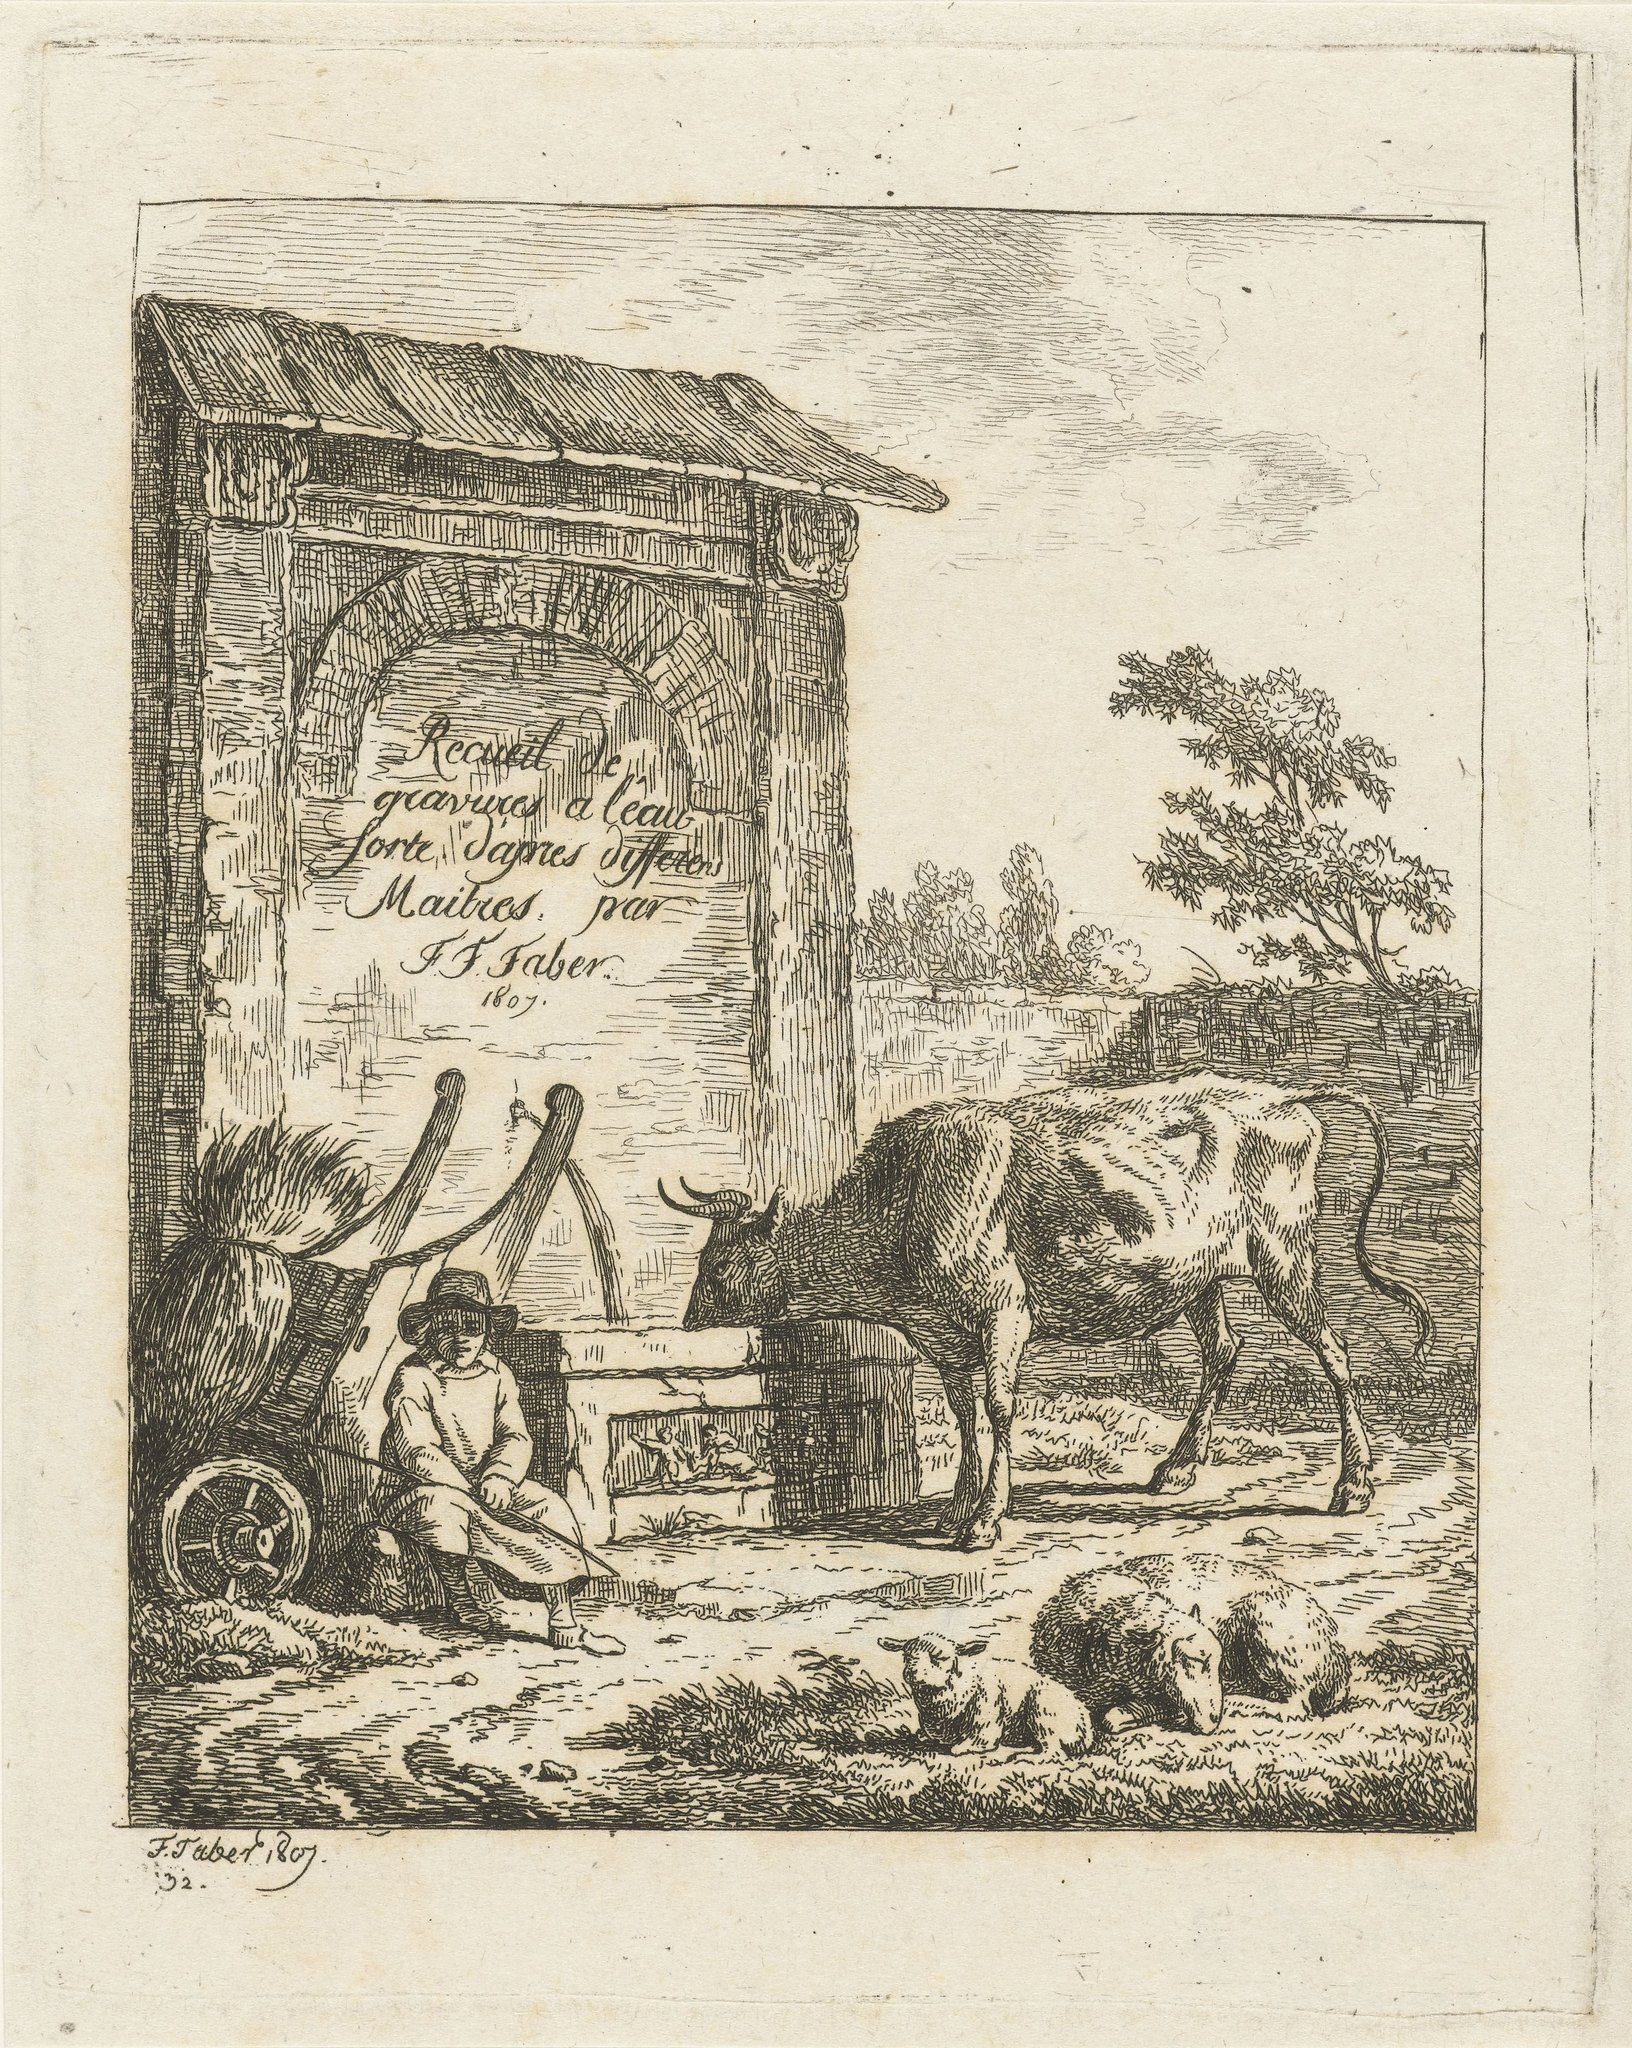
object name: titelprent, frontispice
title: Recueil de gravures a l'eau forte d'apres différents maîtres par F.T. Faber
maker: frédéric théodore faber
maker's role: print maker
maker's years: 1782-1844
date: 1807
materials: paper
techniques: etching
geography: brussels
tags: bull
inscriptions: collector's mark: Lugt 2228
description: Naast een fontein met een afdakje zit een jongen bij een kar met stro. Een rund drinkt uit de waterbak van de fontein. Op de voorgrond een schaap en een lammetje.